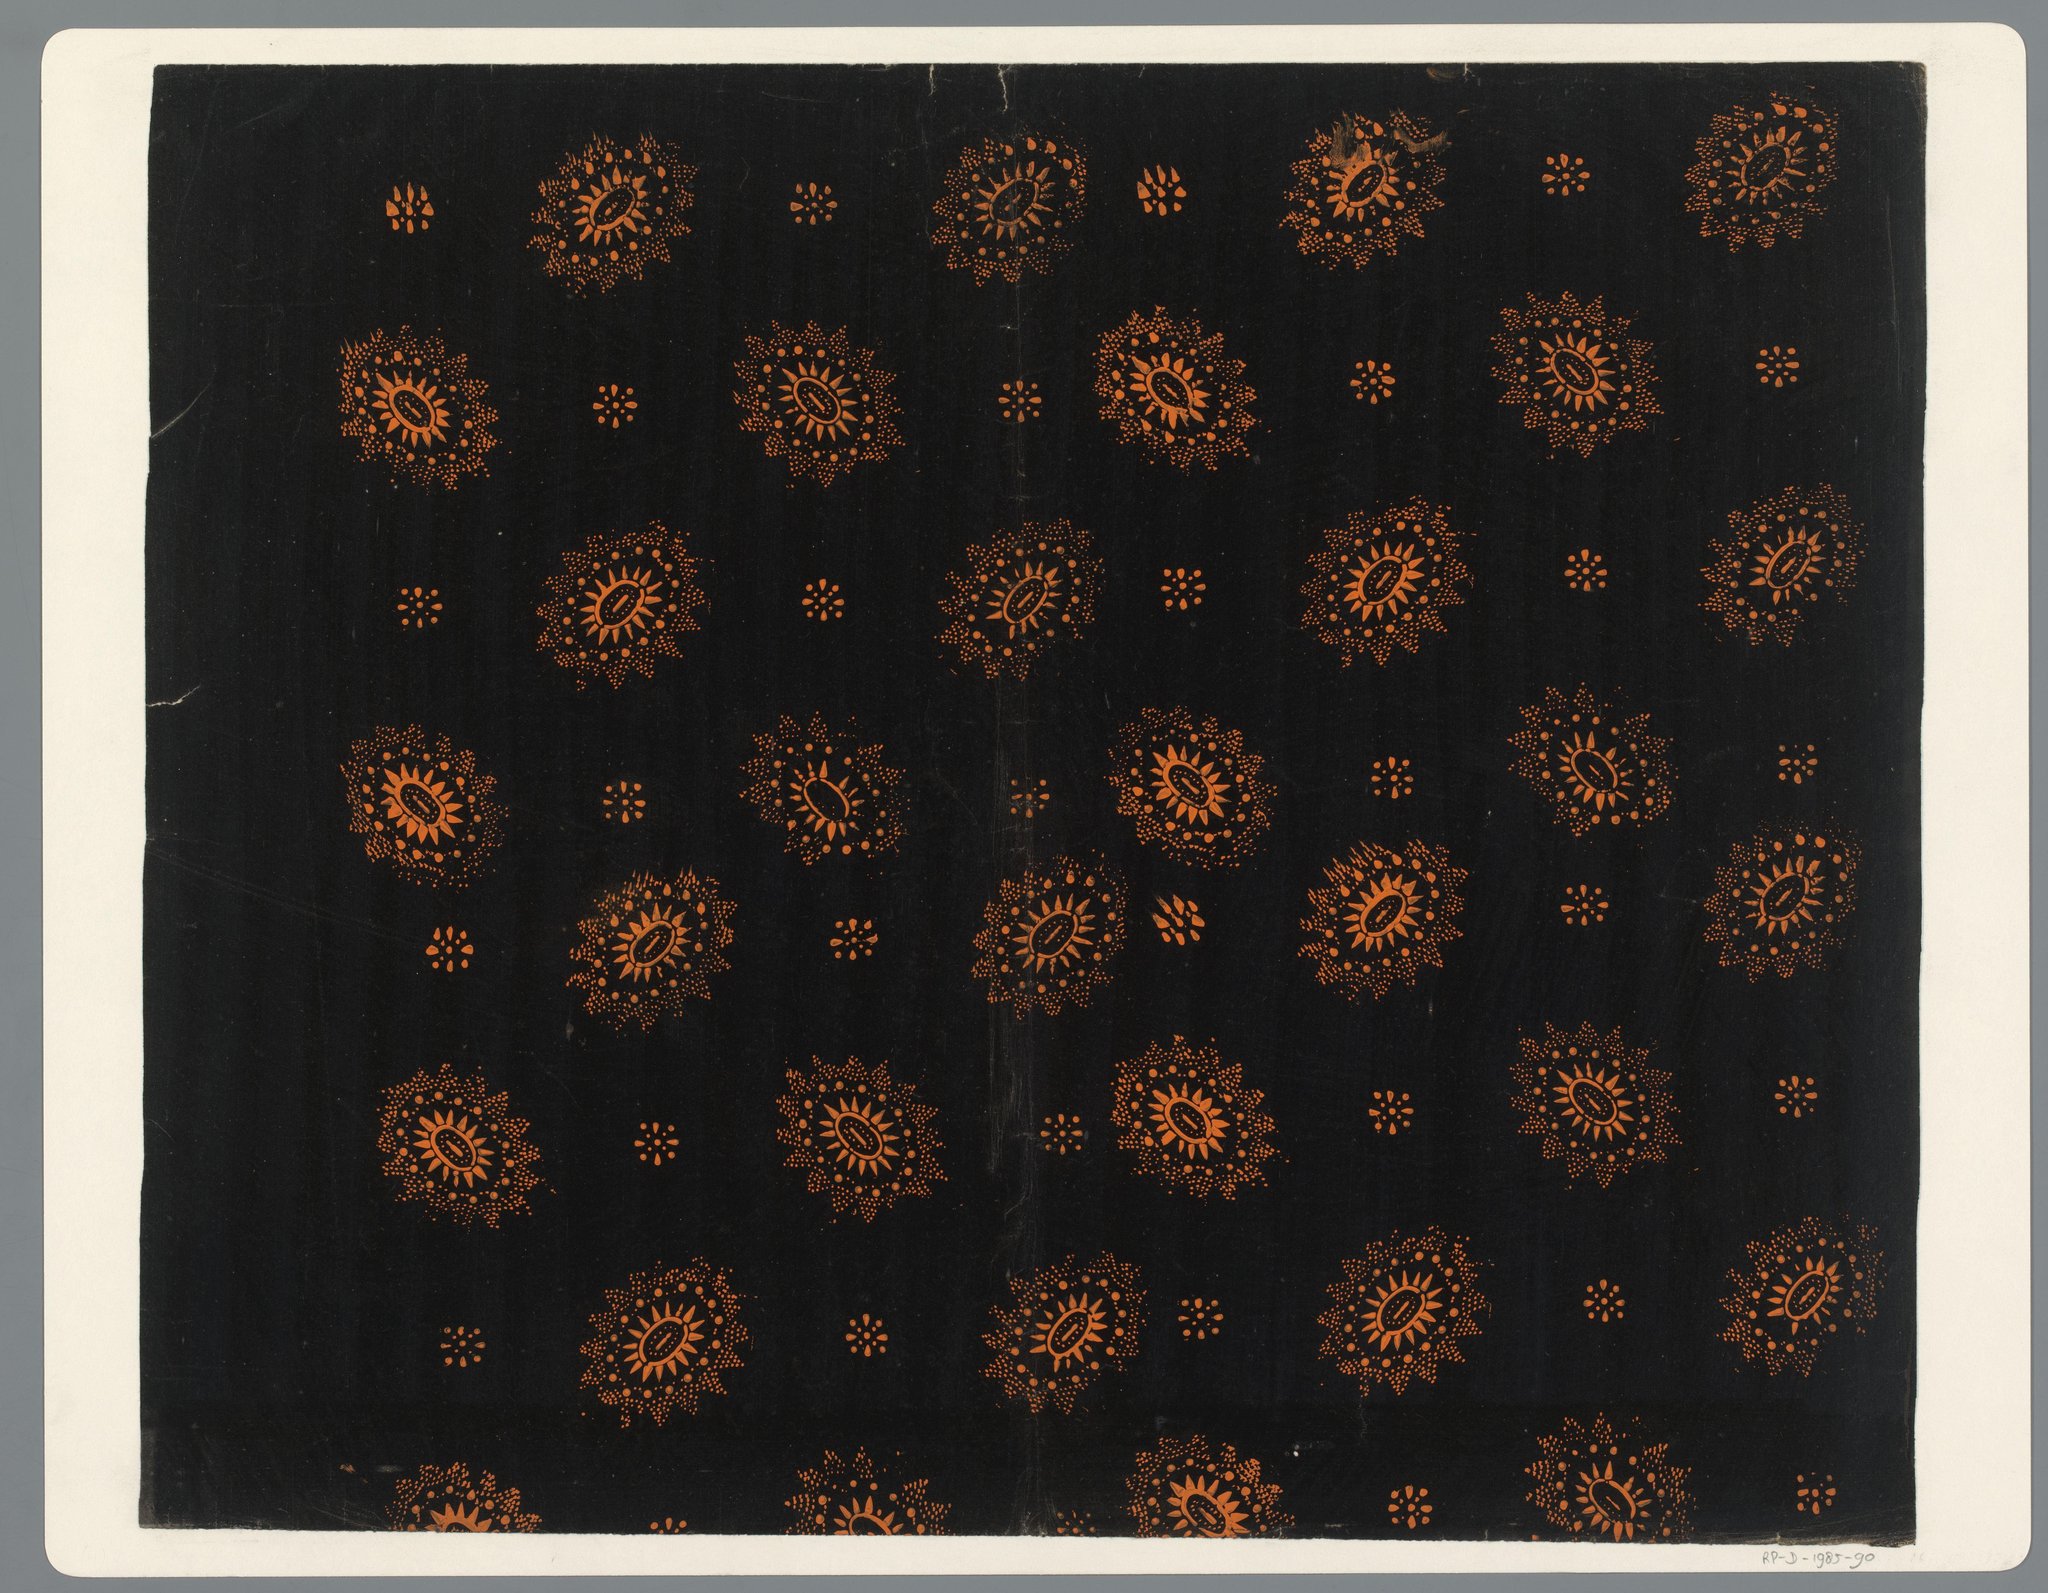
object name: printed paper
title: Blad met strooipatroon van rozetten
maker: Anonymous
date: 1800-1950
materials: lacquer, paper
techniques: printing block, lacquer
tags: ornament derived from plant forms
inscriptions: collector's mark: Lugt 2760, collector's mark: Lugt 2228